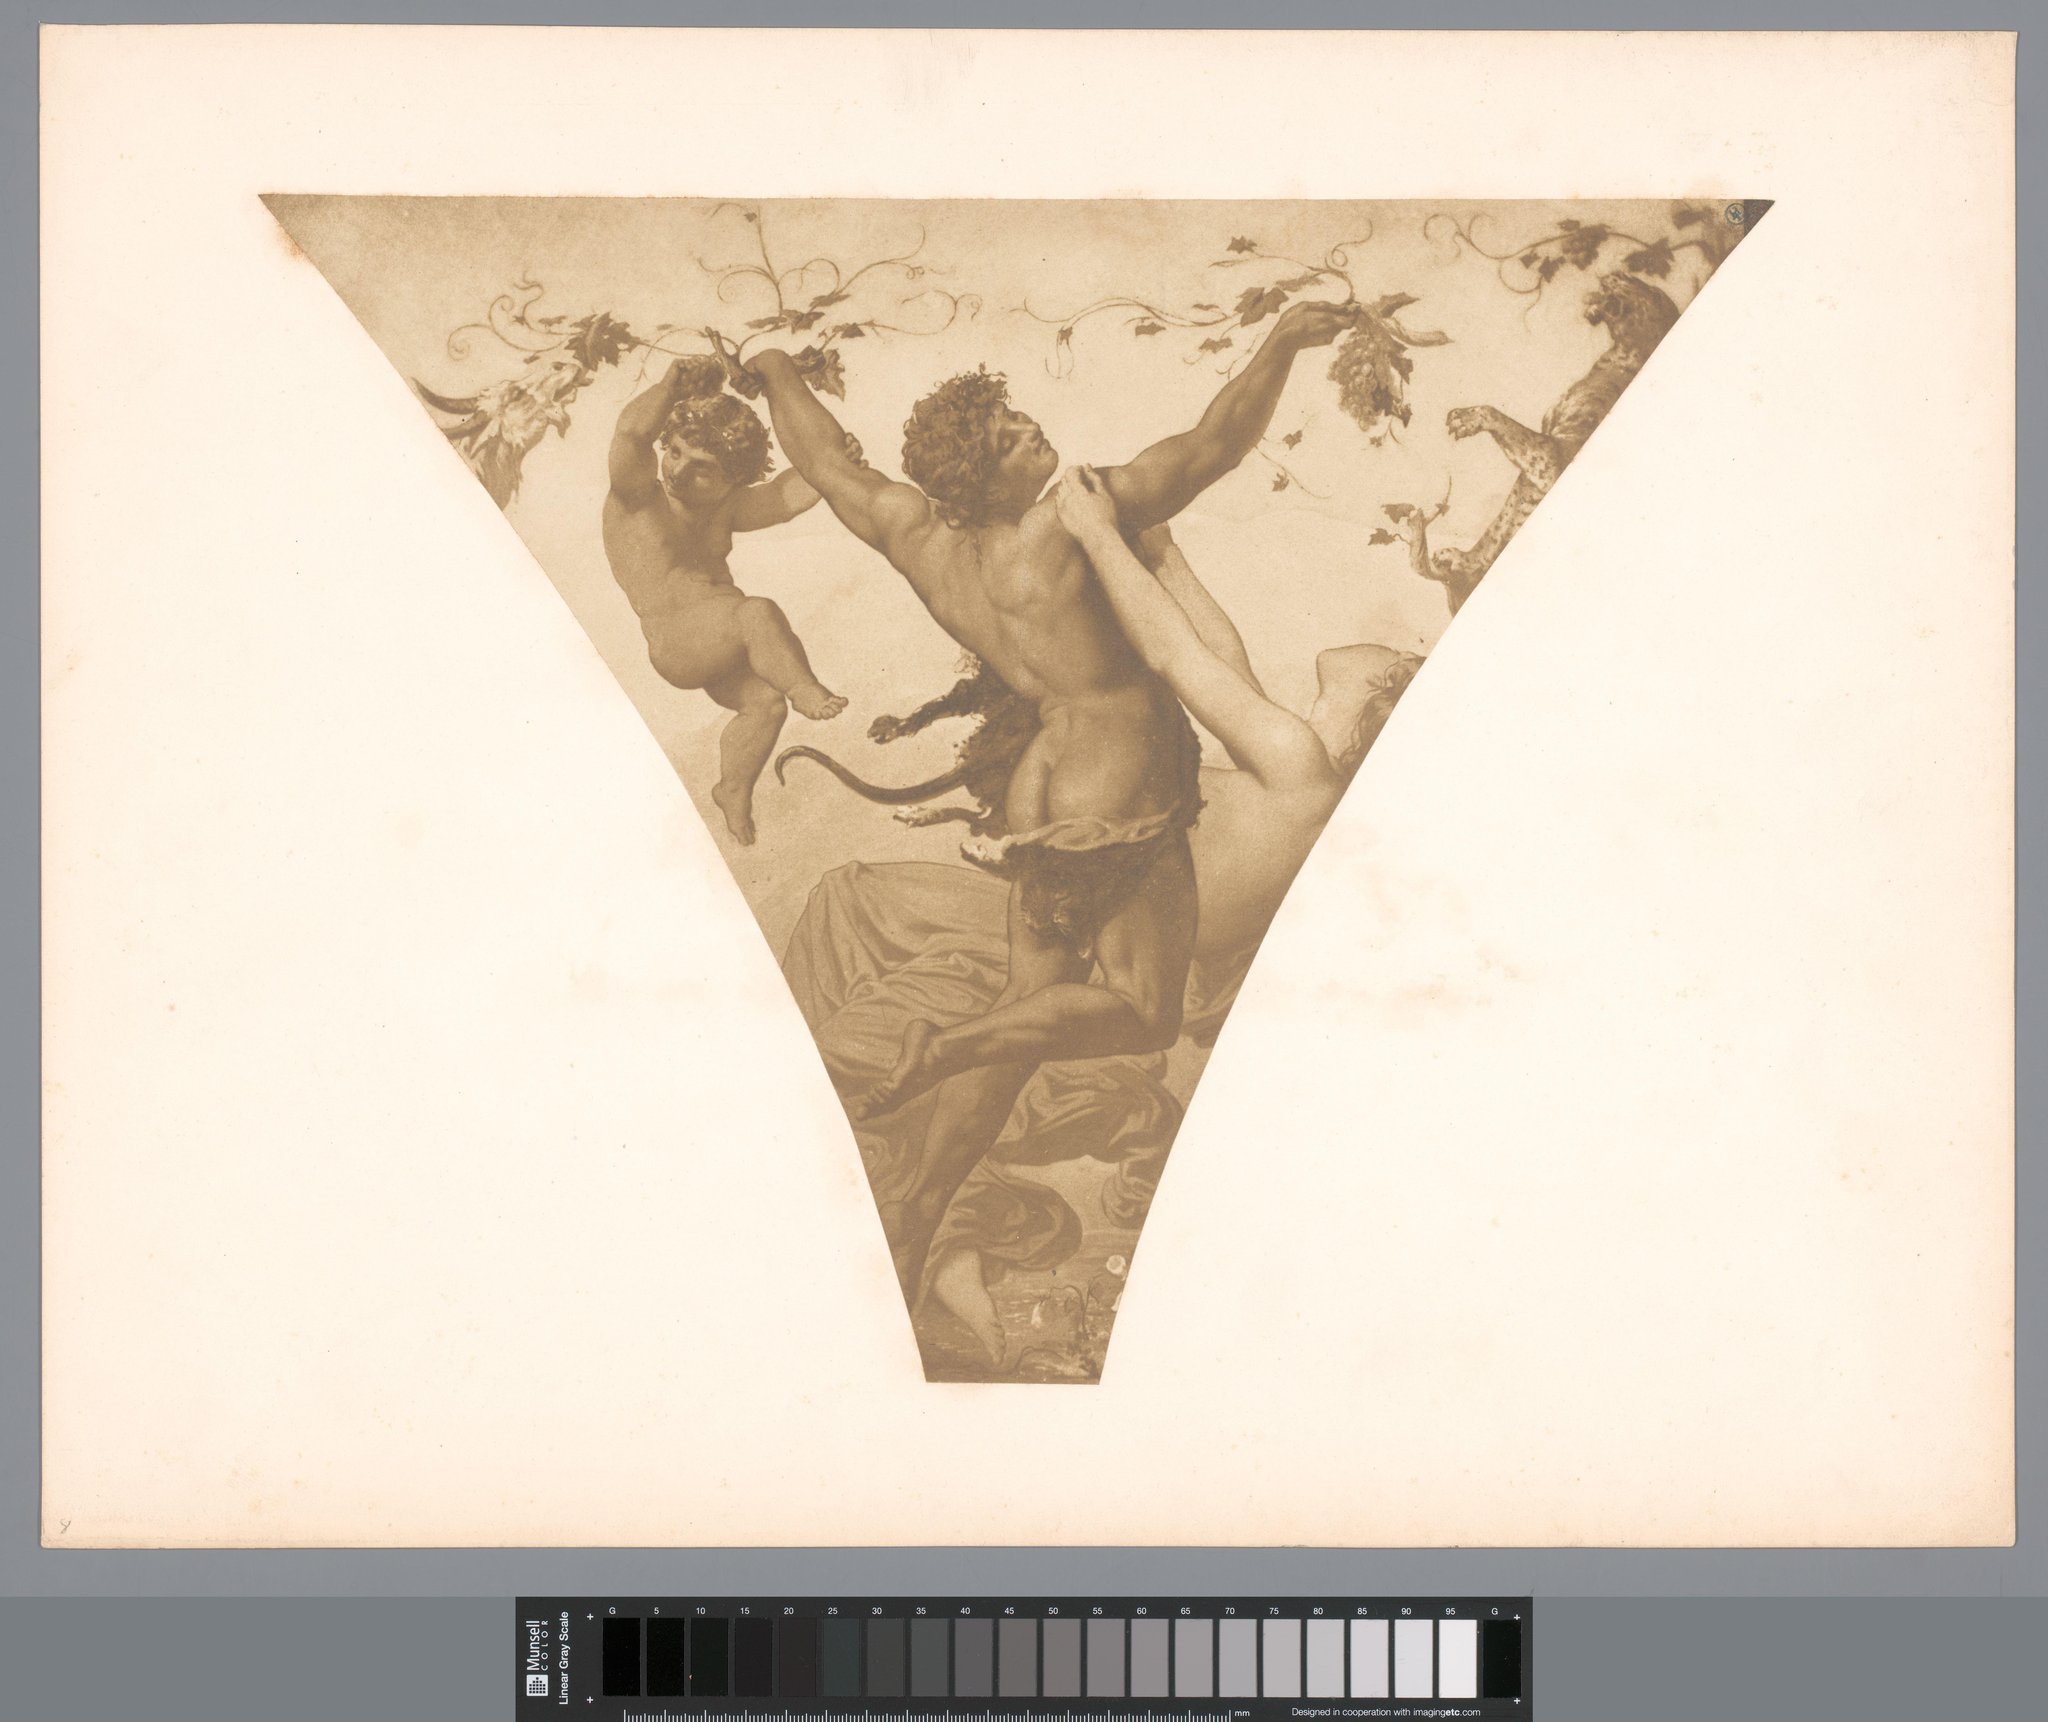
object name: photograph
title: Fotografische reproductie van decoratie aan plafond, Hotel de Ville, Parijs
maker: gustave le gray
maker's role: fotograaf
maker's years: 1820-1884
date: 1852-1853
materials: cardboard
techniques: salted paper print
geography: paris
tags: paris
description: Maakt onderdeel uit van een serie van 18 bladen met foto's van de cartons voor de plafondschilderingen door Henri Lehmann voor de Galerie des Fêtes in het Hotel de Ville, Parijs.